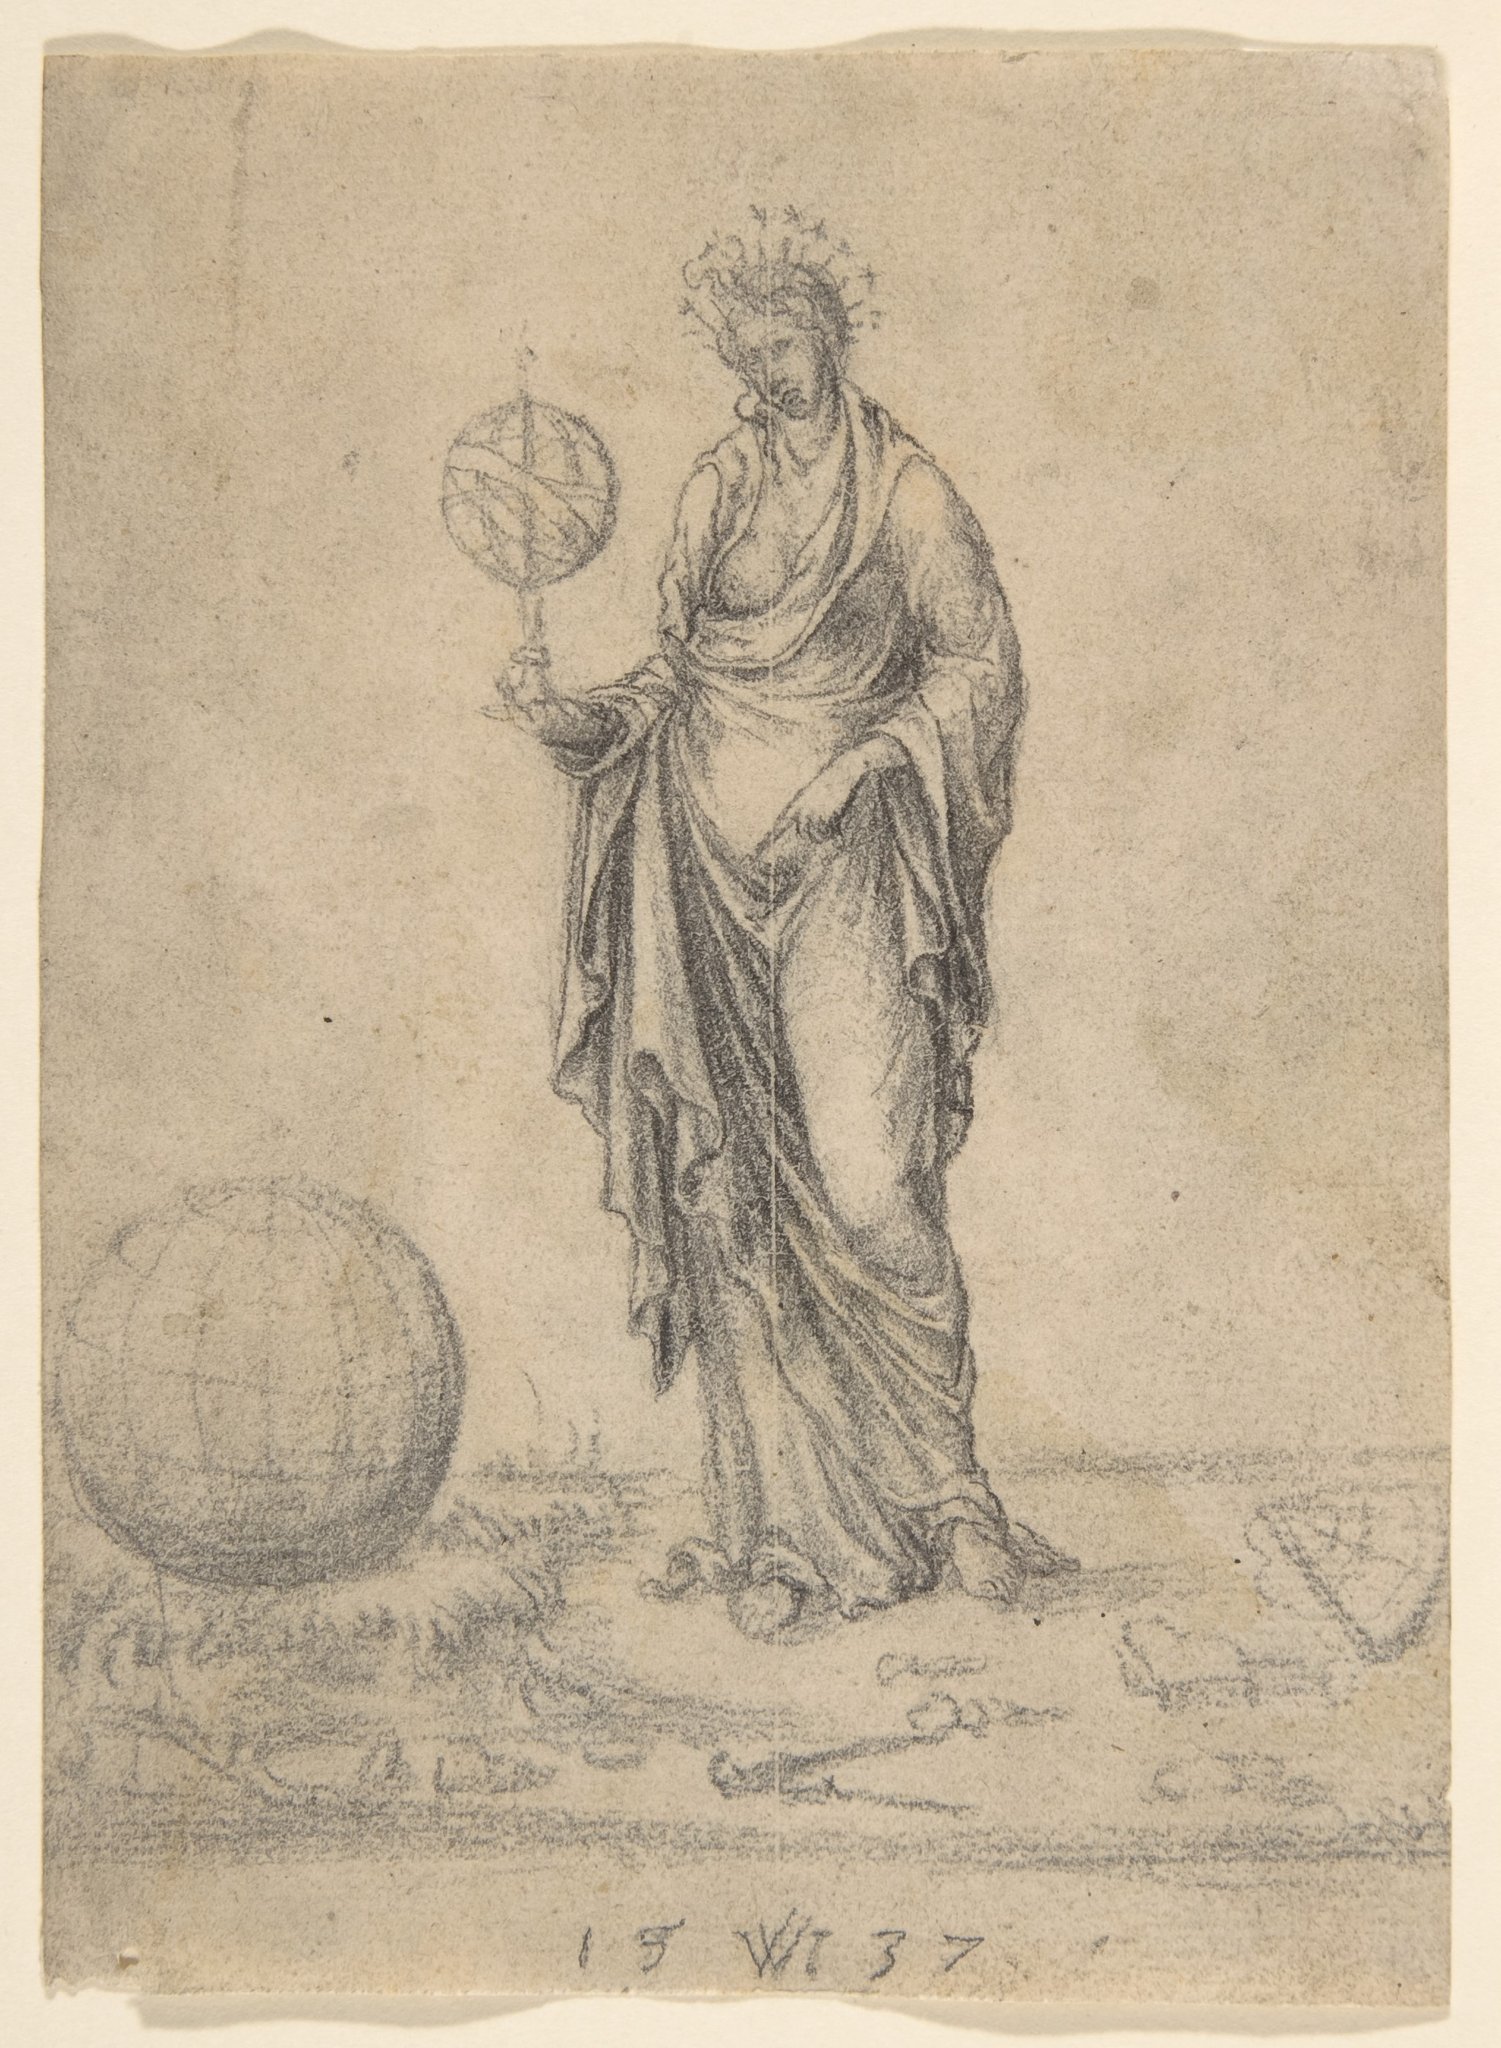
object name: drawing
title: Urania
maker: wenzel jamnitzer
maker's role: artist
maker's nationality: german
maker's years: 1507-1585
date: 1520-1585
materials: chalk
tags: muses,globes